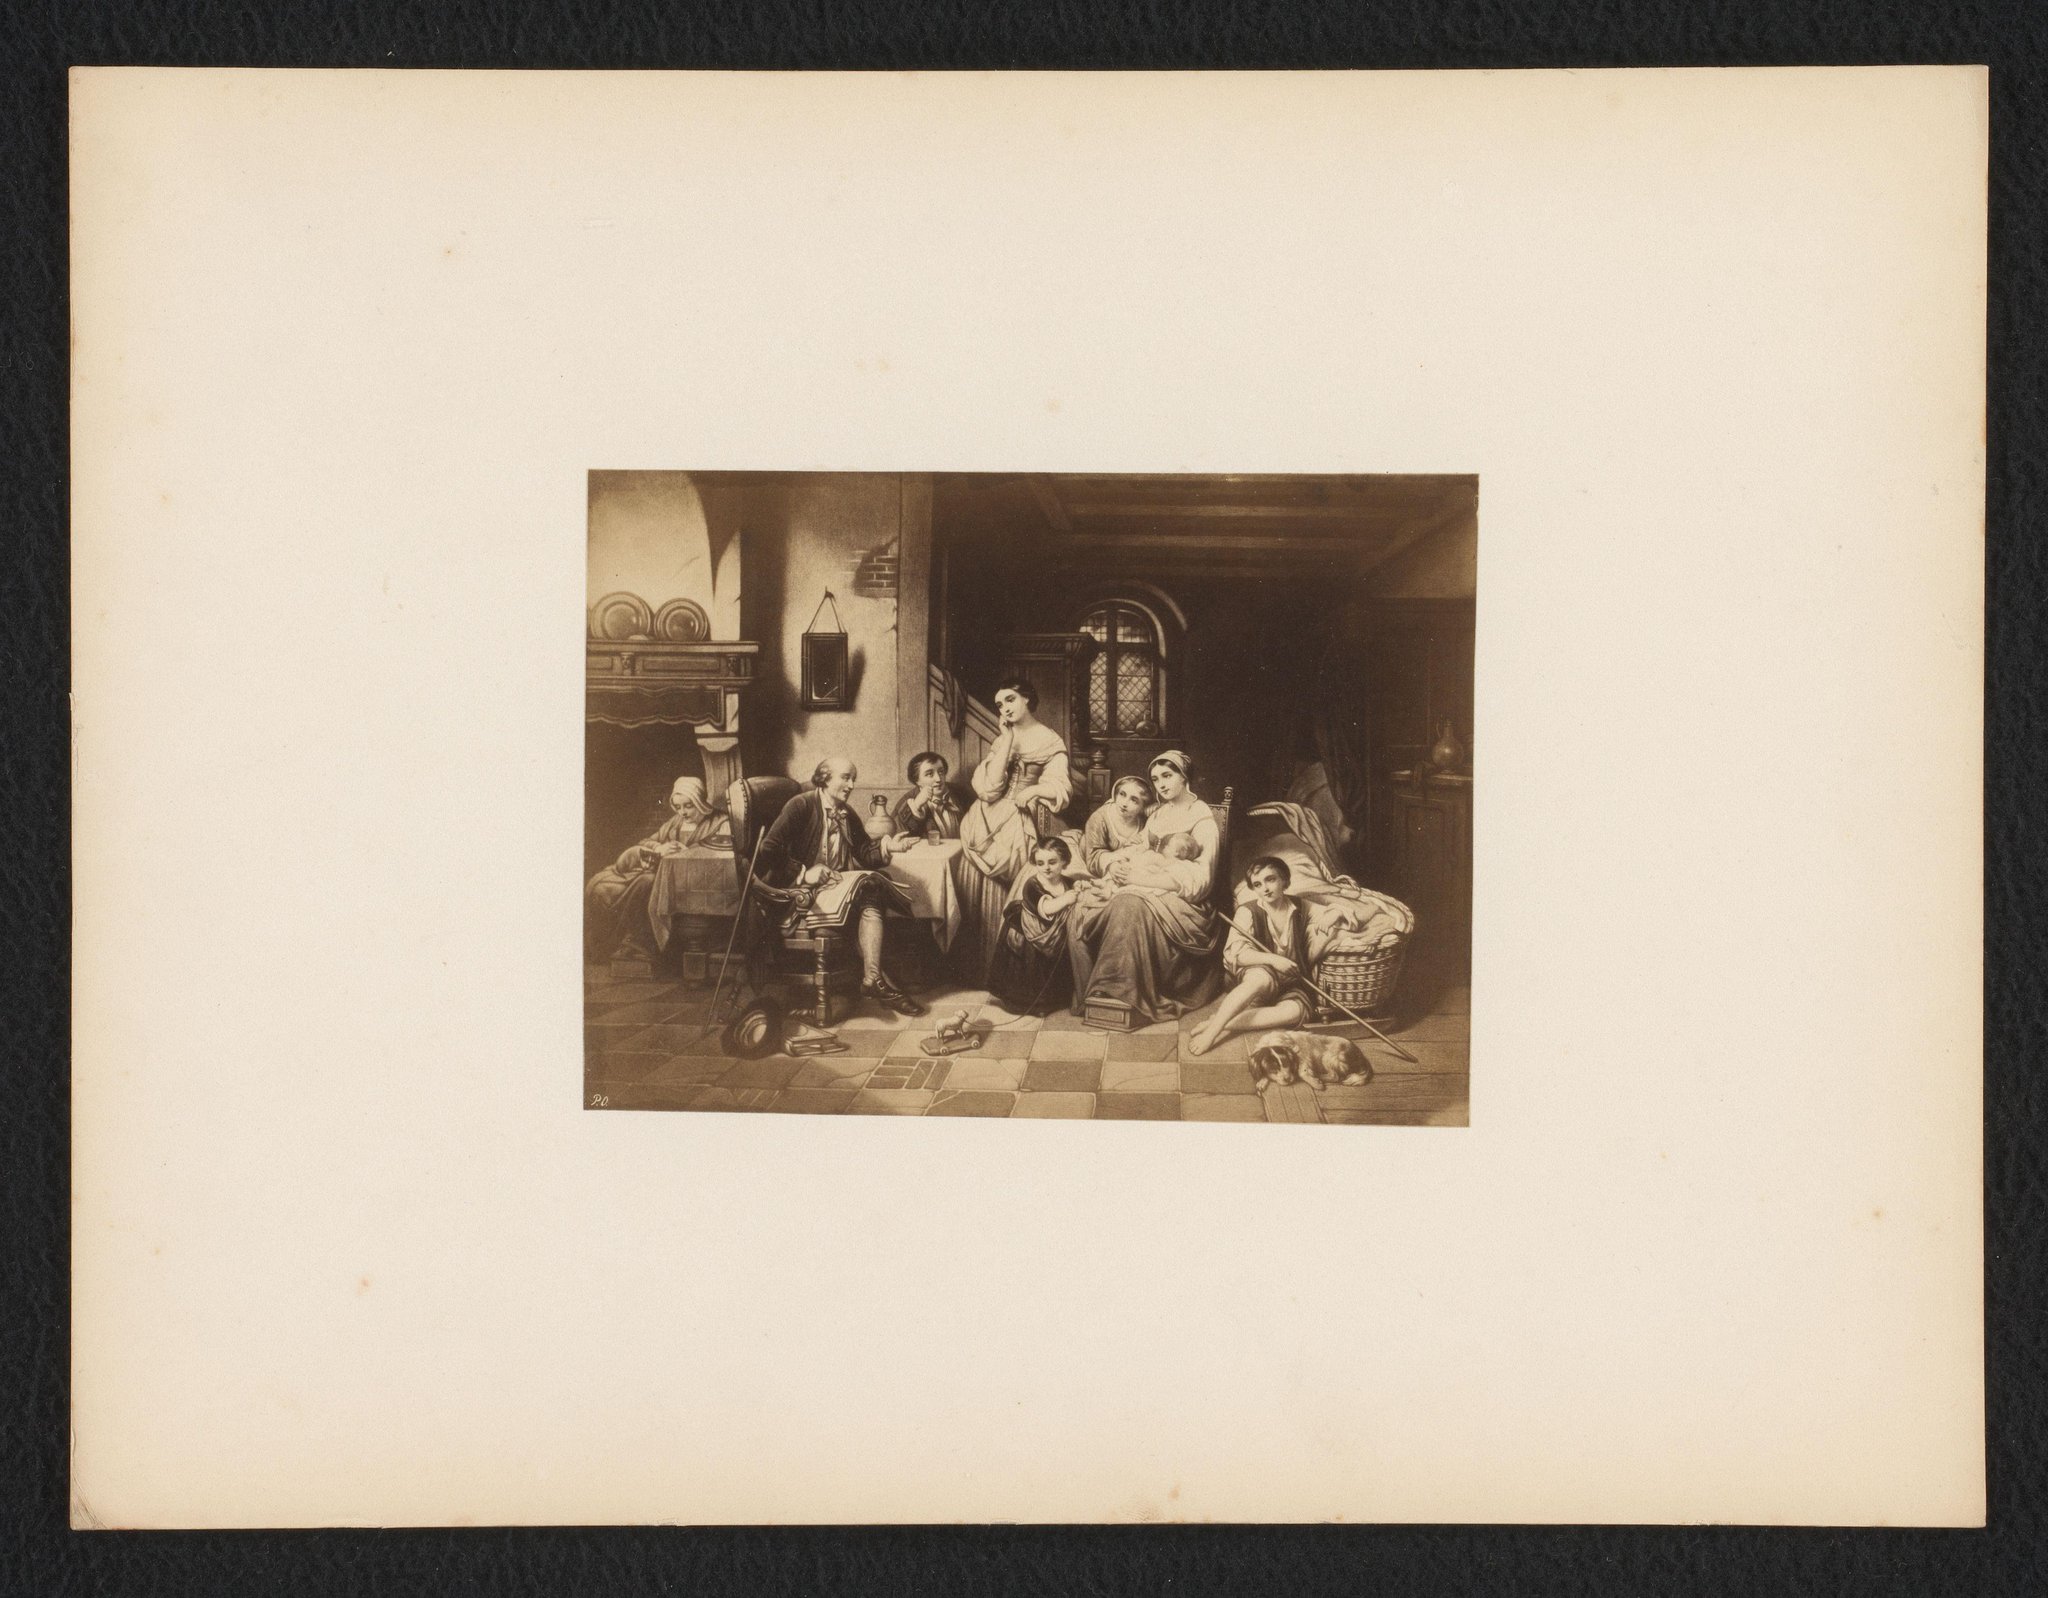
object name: reproduction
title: Fotoreproductie van het schilderij L'Explication de la Bible naar Hunin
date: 1860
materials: cardboard, paper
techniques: albumen print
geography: amsterdam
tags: picture, painting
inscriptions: monogram: ‘P.O.’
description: Deze foto maakt deel uit van een omslag.